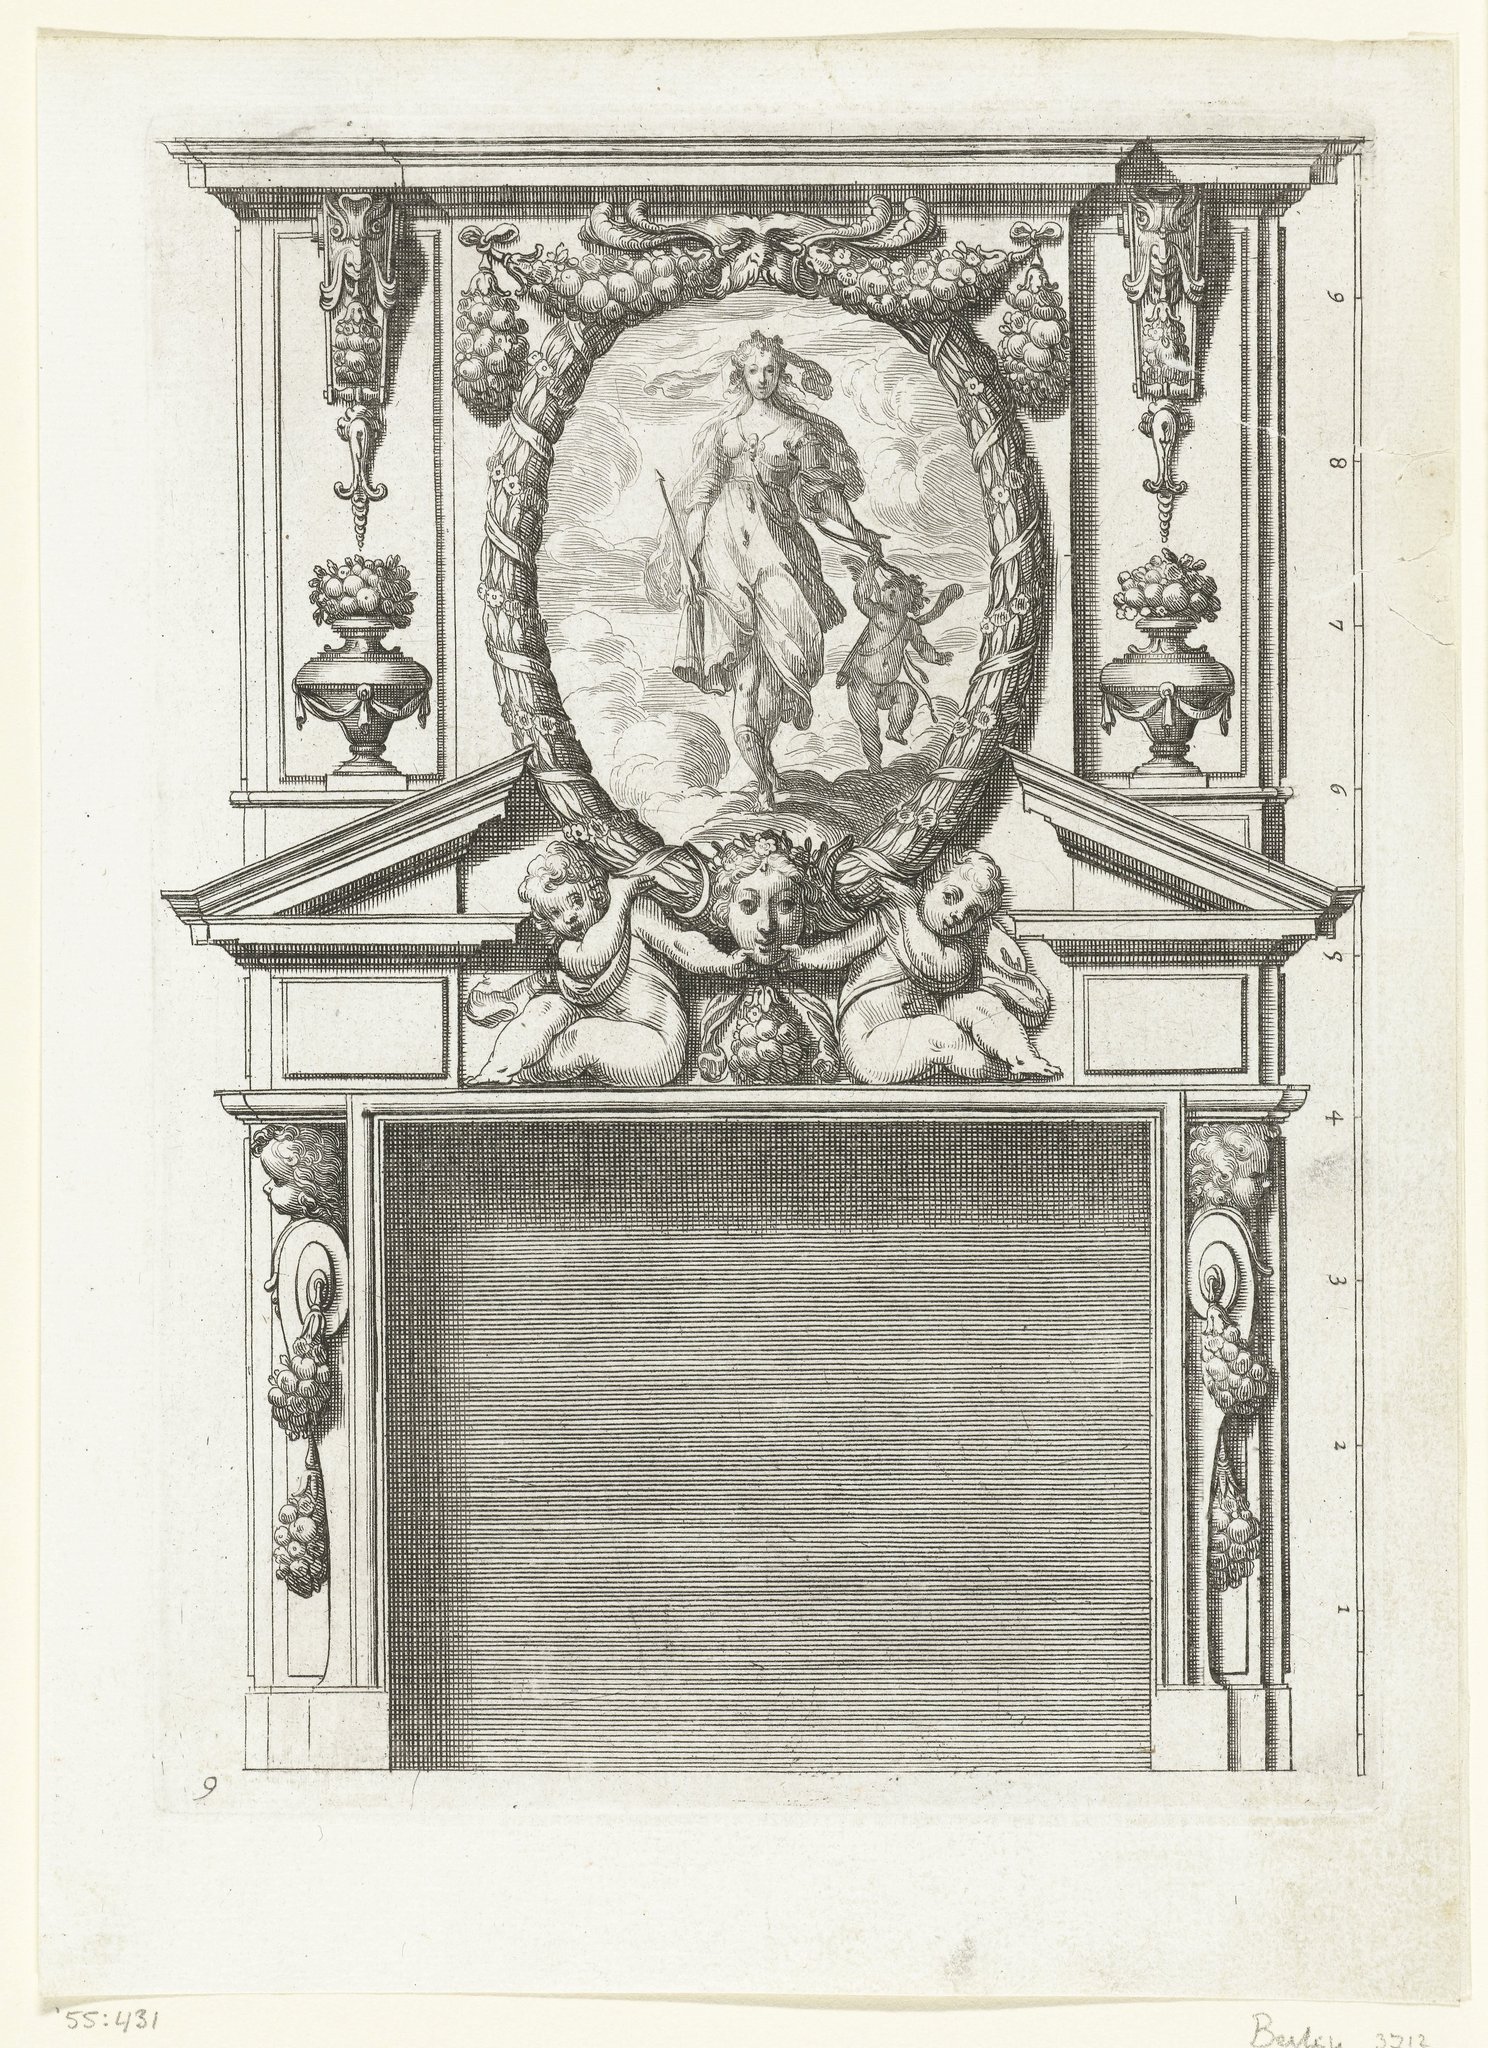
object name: print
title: Onderboezem, schacht gedecoreerd met Venus en Cupido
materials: paper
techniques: etching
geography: france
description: Blad 9 uit tweede uitgave van serie. De nummering van de prenten komt slechts gedeeltelijk overeen met die van de eerste editie.